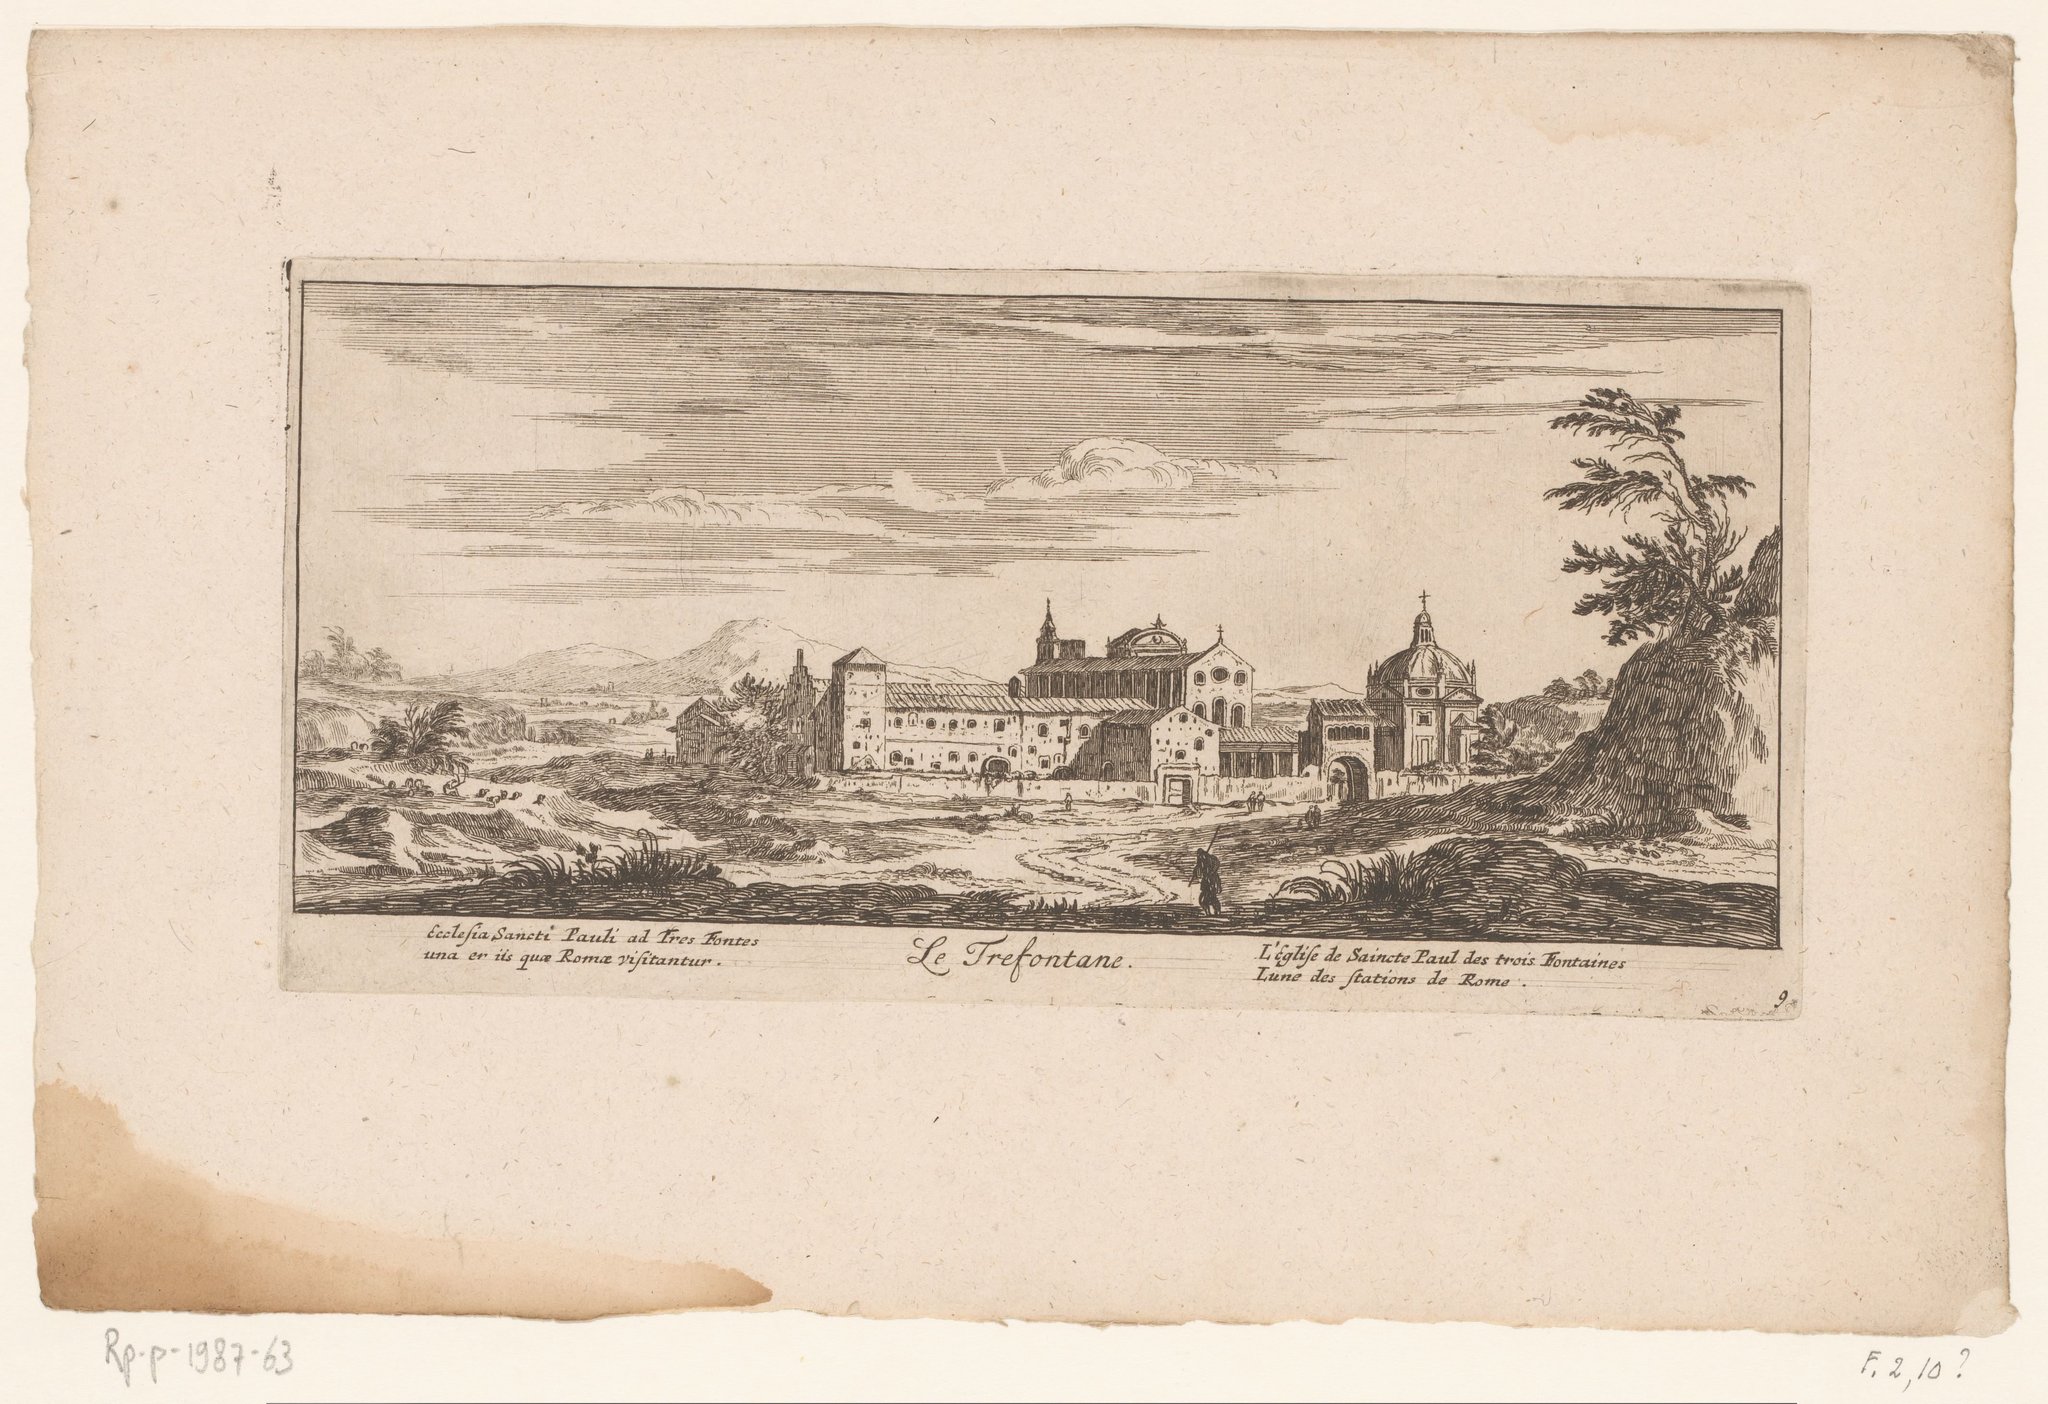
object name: print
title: Gezicht op de Abdij Tre Fontane, te Rome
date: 1648-1712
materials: paper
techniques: etching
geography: amsterdam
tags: abbey, monastery, convent ~ roman catholic church, church (exterior)